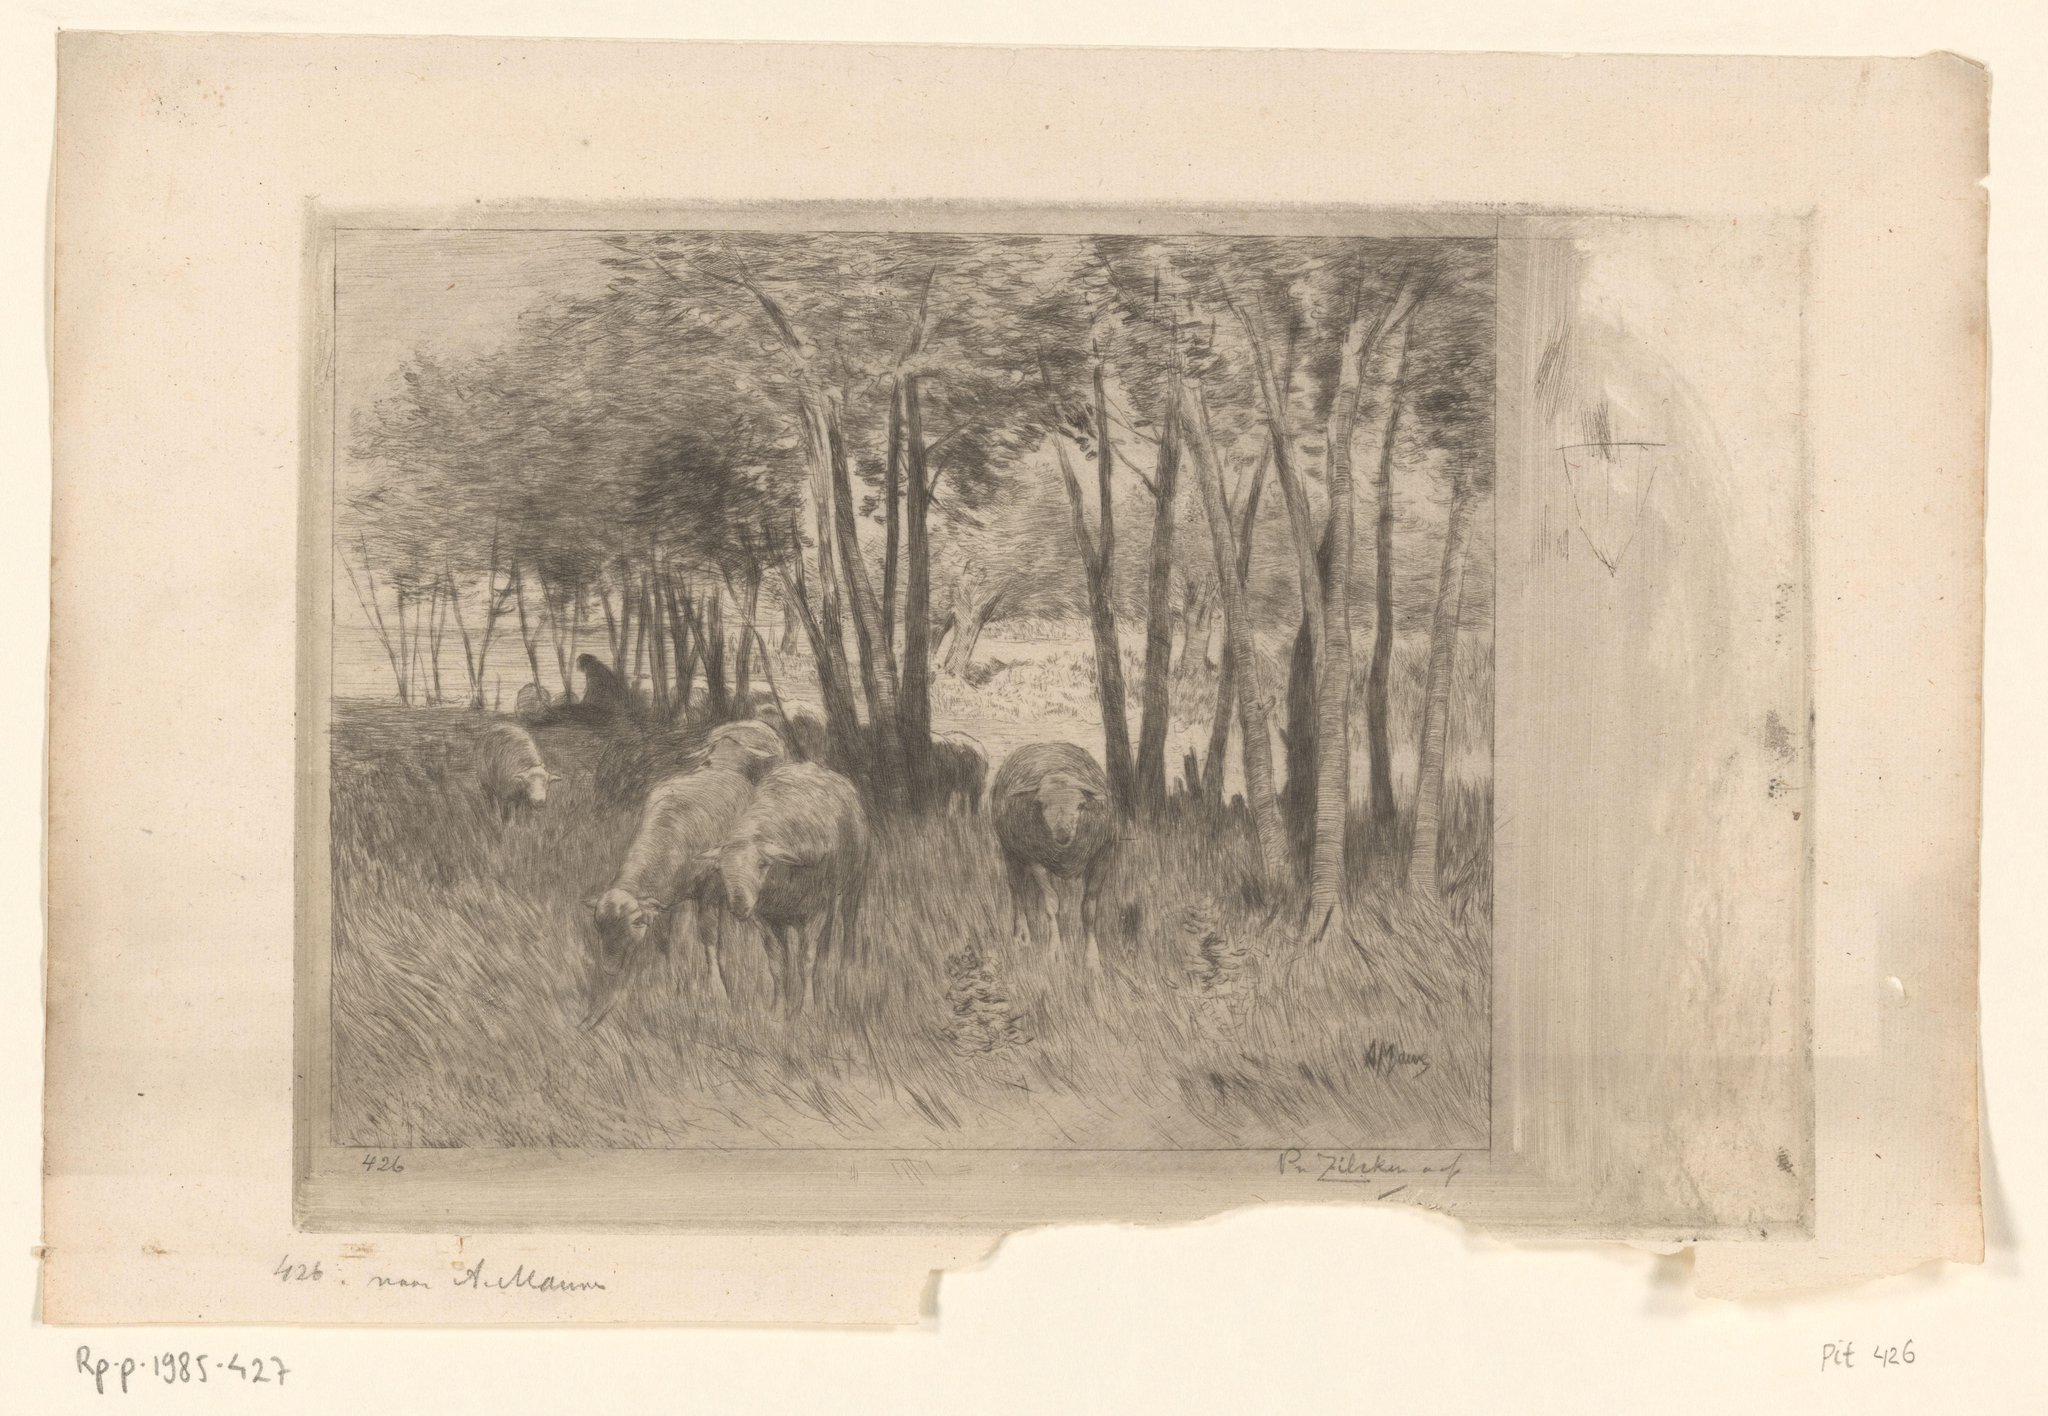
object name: print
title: Moutons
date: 1890-1930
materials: paper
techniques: drypoint, intaglio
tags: meadow, pasture, sheep, herd, flock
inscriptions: collector's mark: Lugt 2760, collector's mark: Lugt 2228